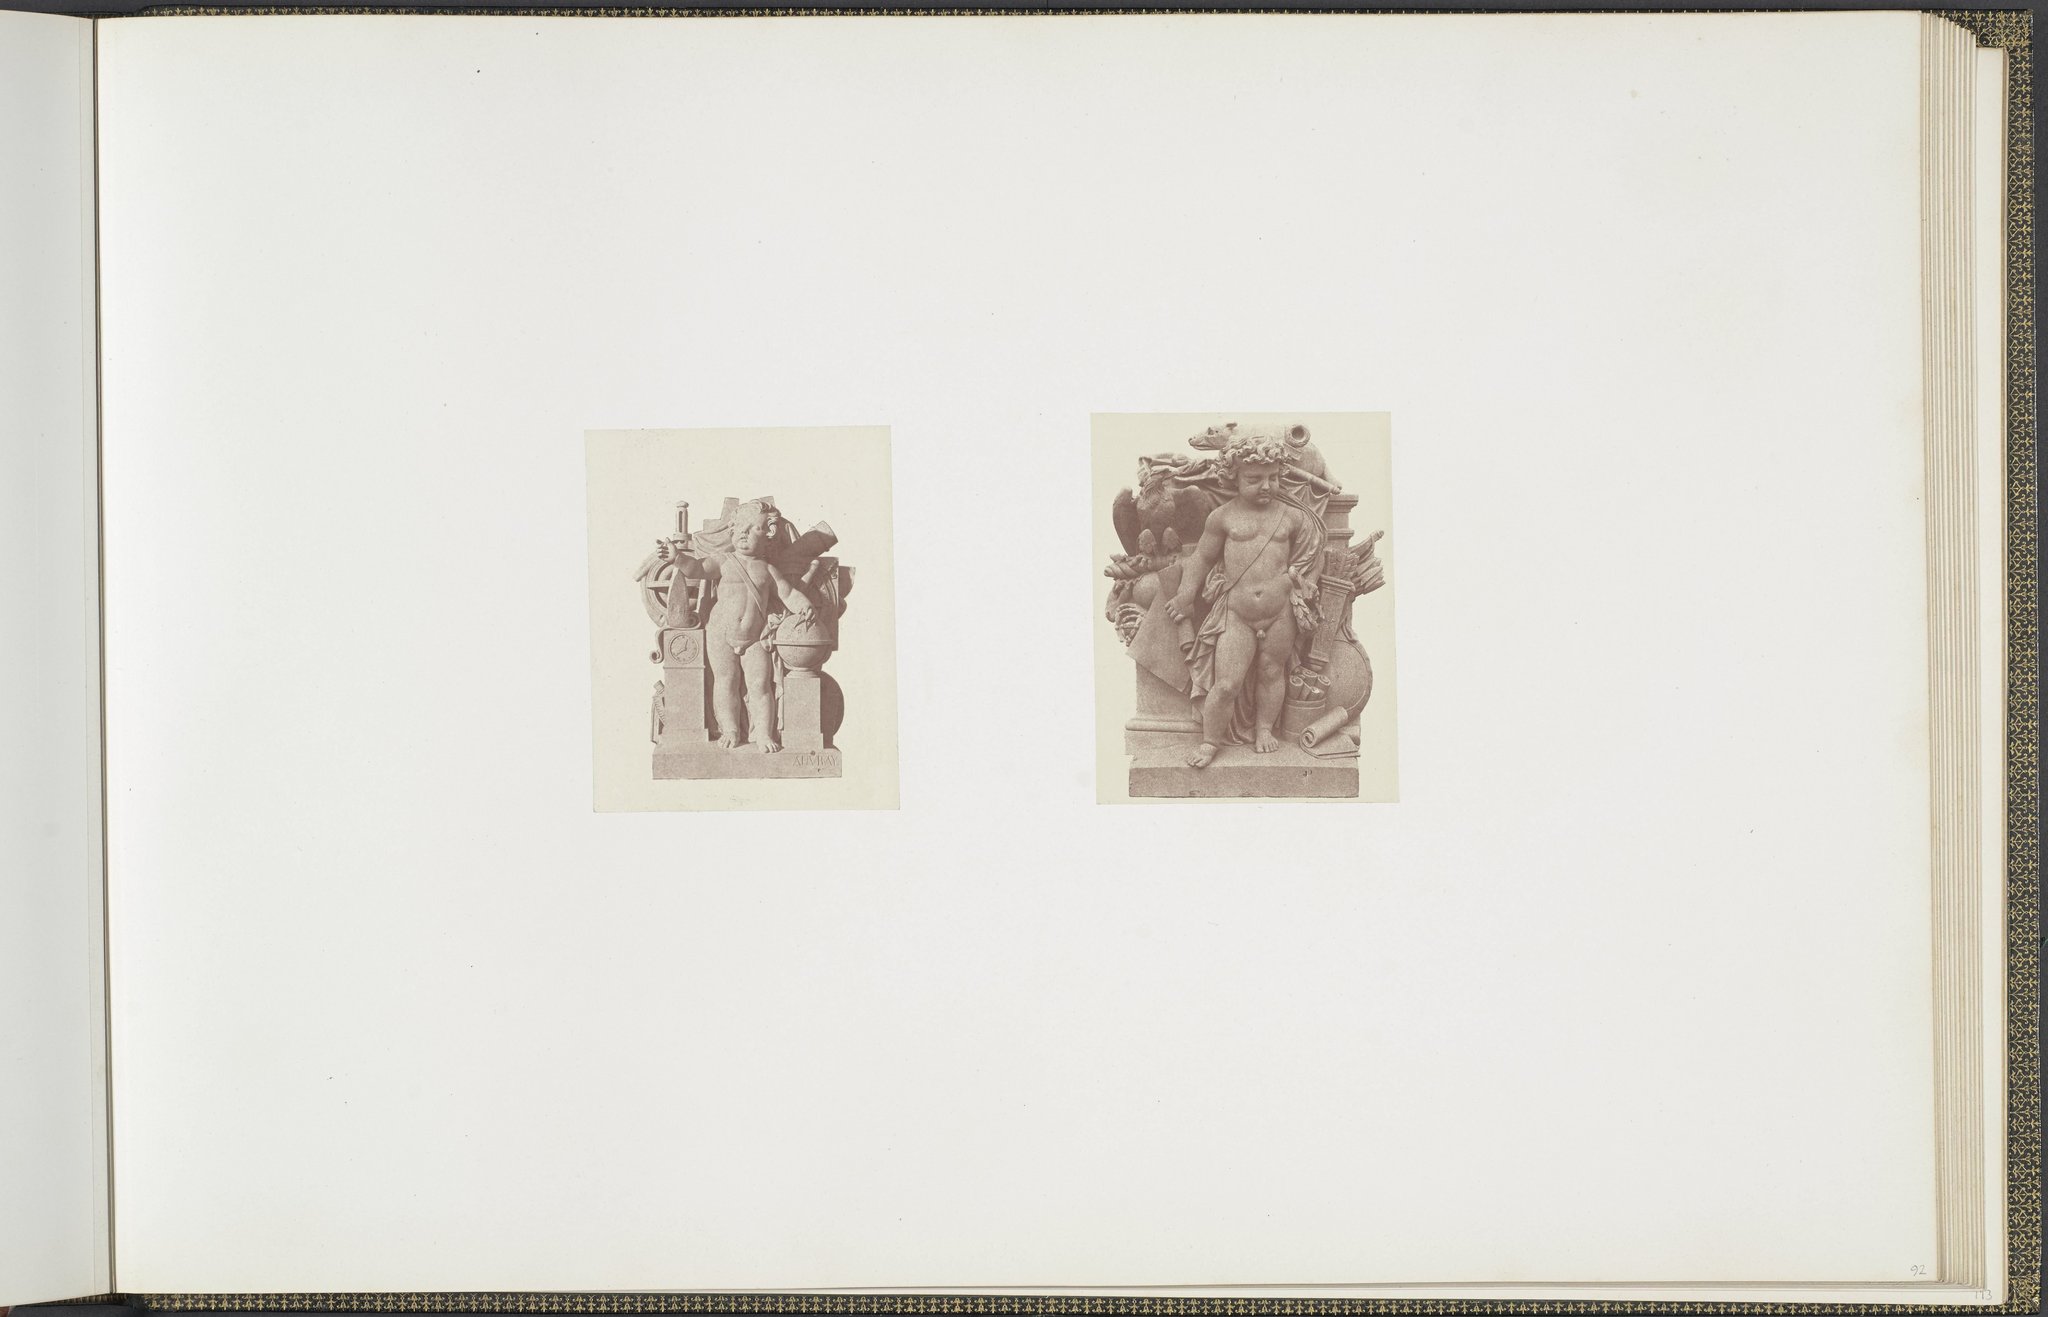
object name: album leaf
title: Gipsmodellen voor beeldhouwwerken op het Palais du Louvre: links "L'Astronomie" door Louis Auvray en rechts "L'Art romain" door Ferdinand Taluet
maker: édouard denis baldus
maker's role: fotograaf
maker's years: 1813-1889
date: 1855-1857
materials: paper, photographic support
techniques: salted paper print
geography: paris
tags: piece of sculpture, reproduction of a piece of sculpture, permanent exhibition, museum, paris, tuileries palace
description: Onderdeel van Réunion des Tuileries au Louvre 1852-1857, album 1.